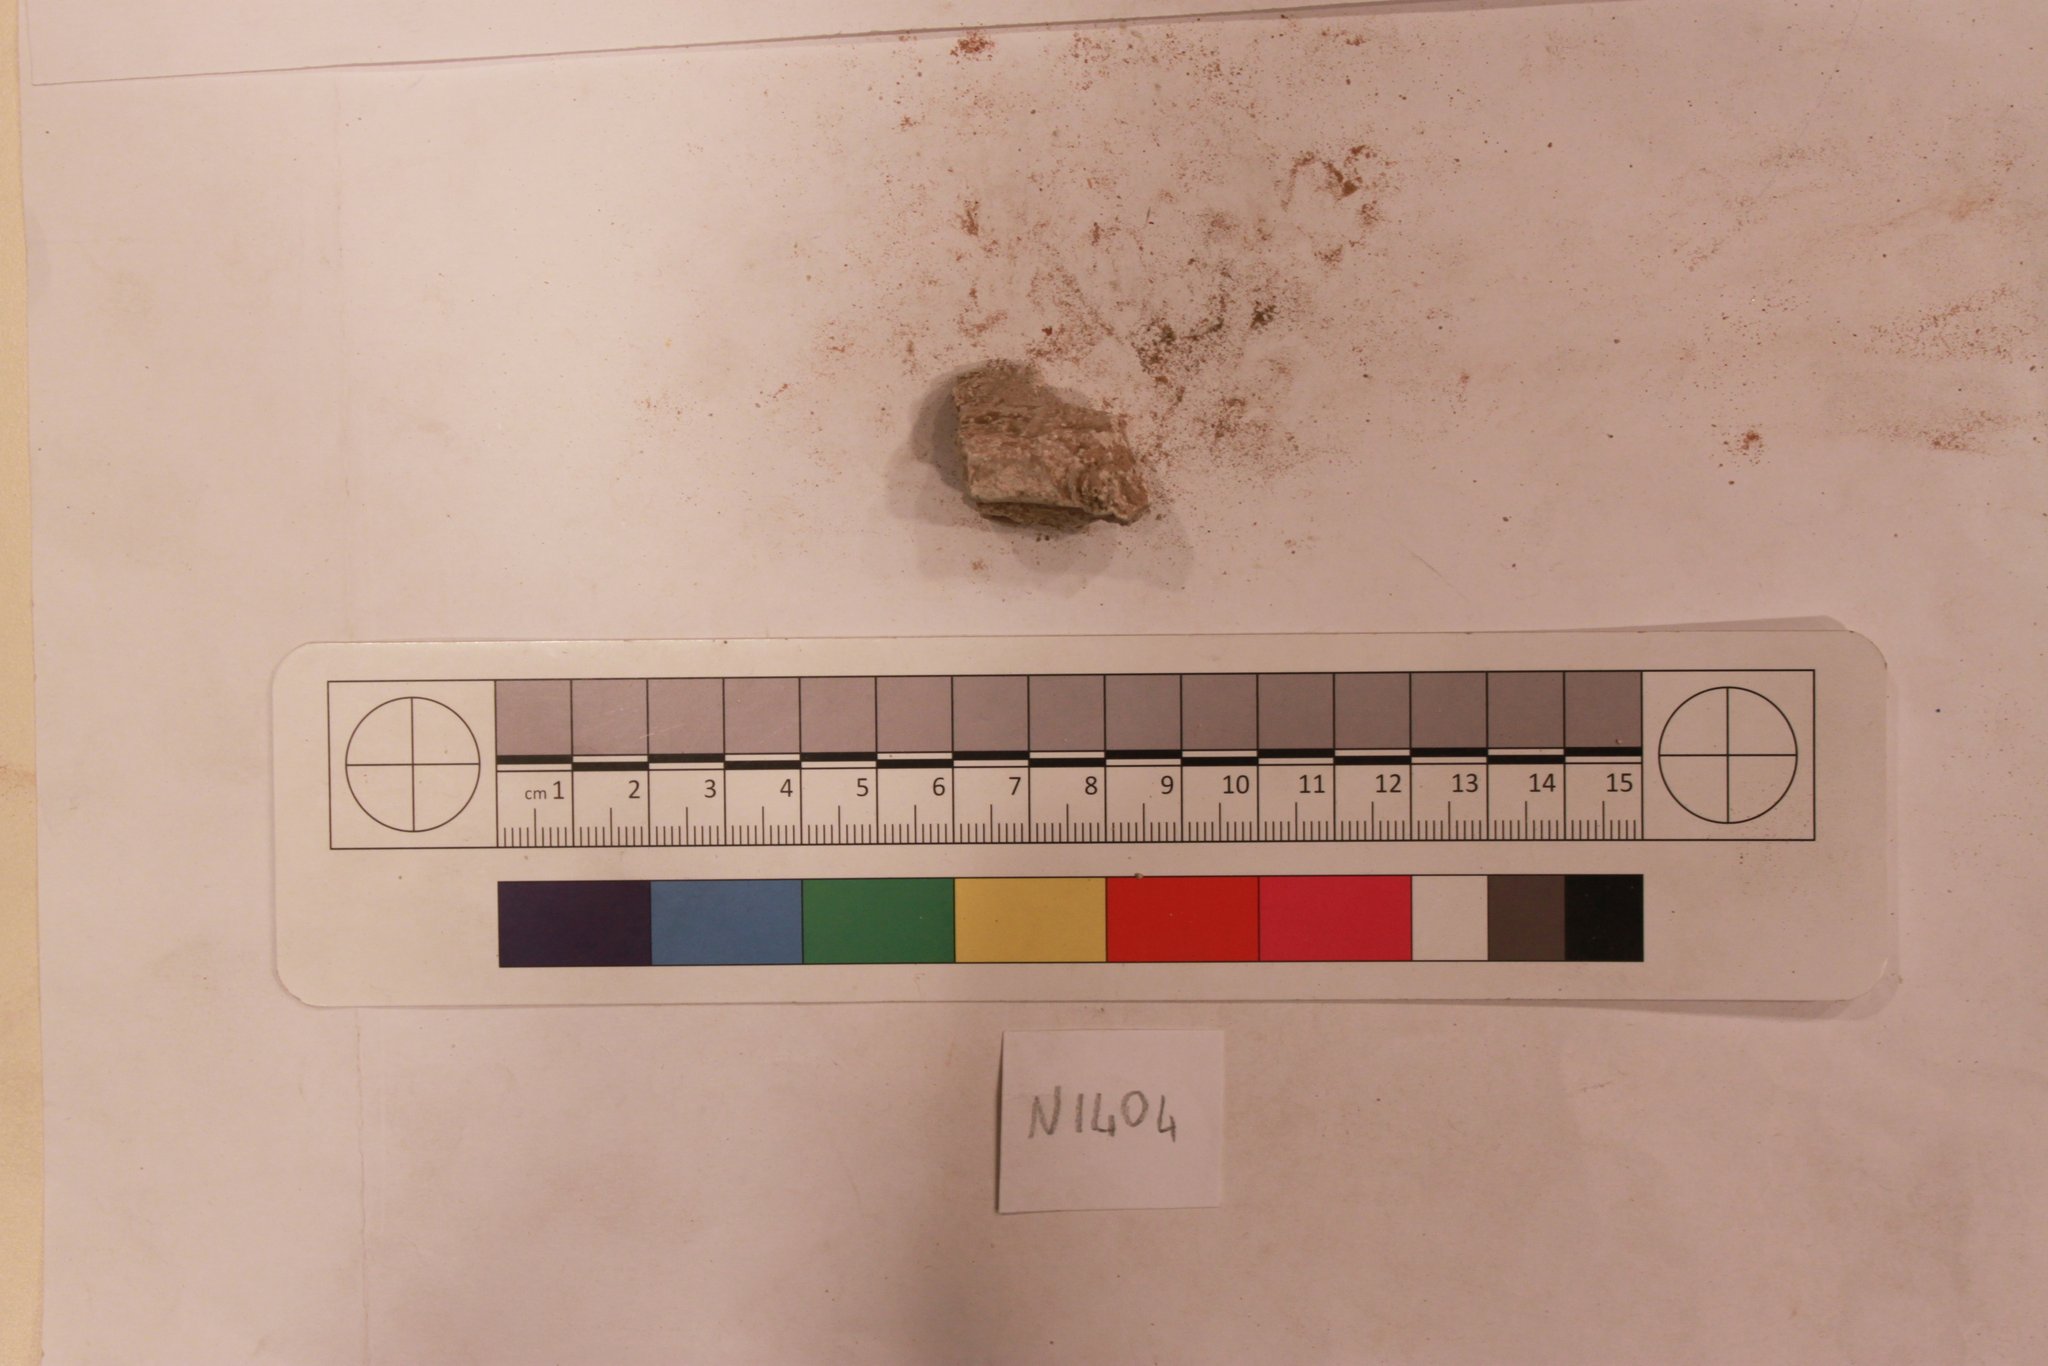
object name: fragment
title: Stucco Fragment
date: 701-1200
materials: plaster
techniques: carving, painting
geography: iran